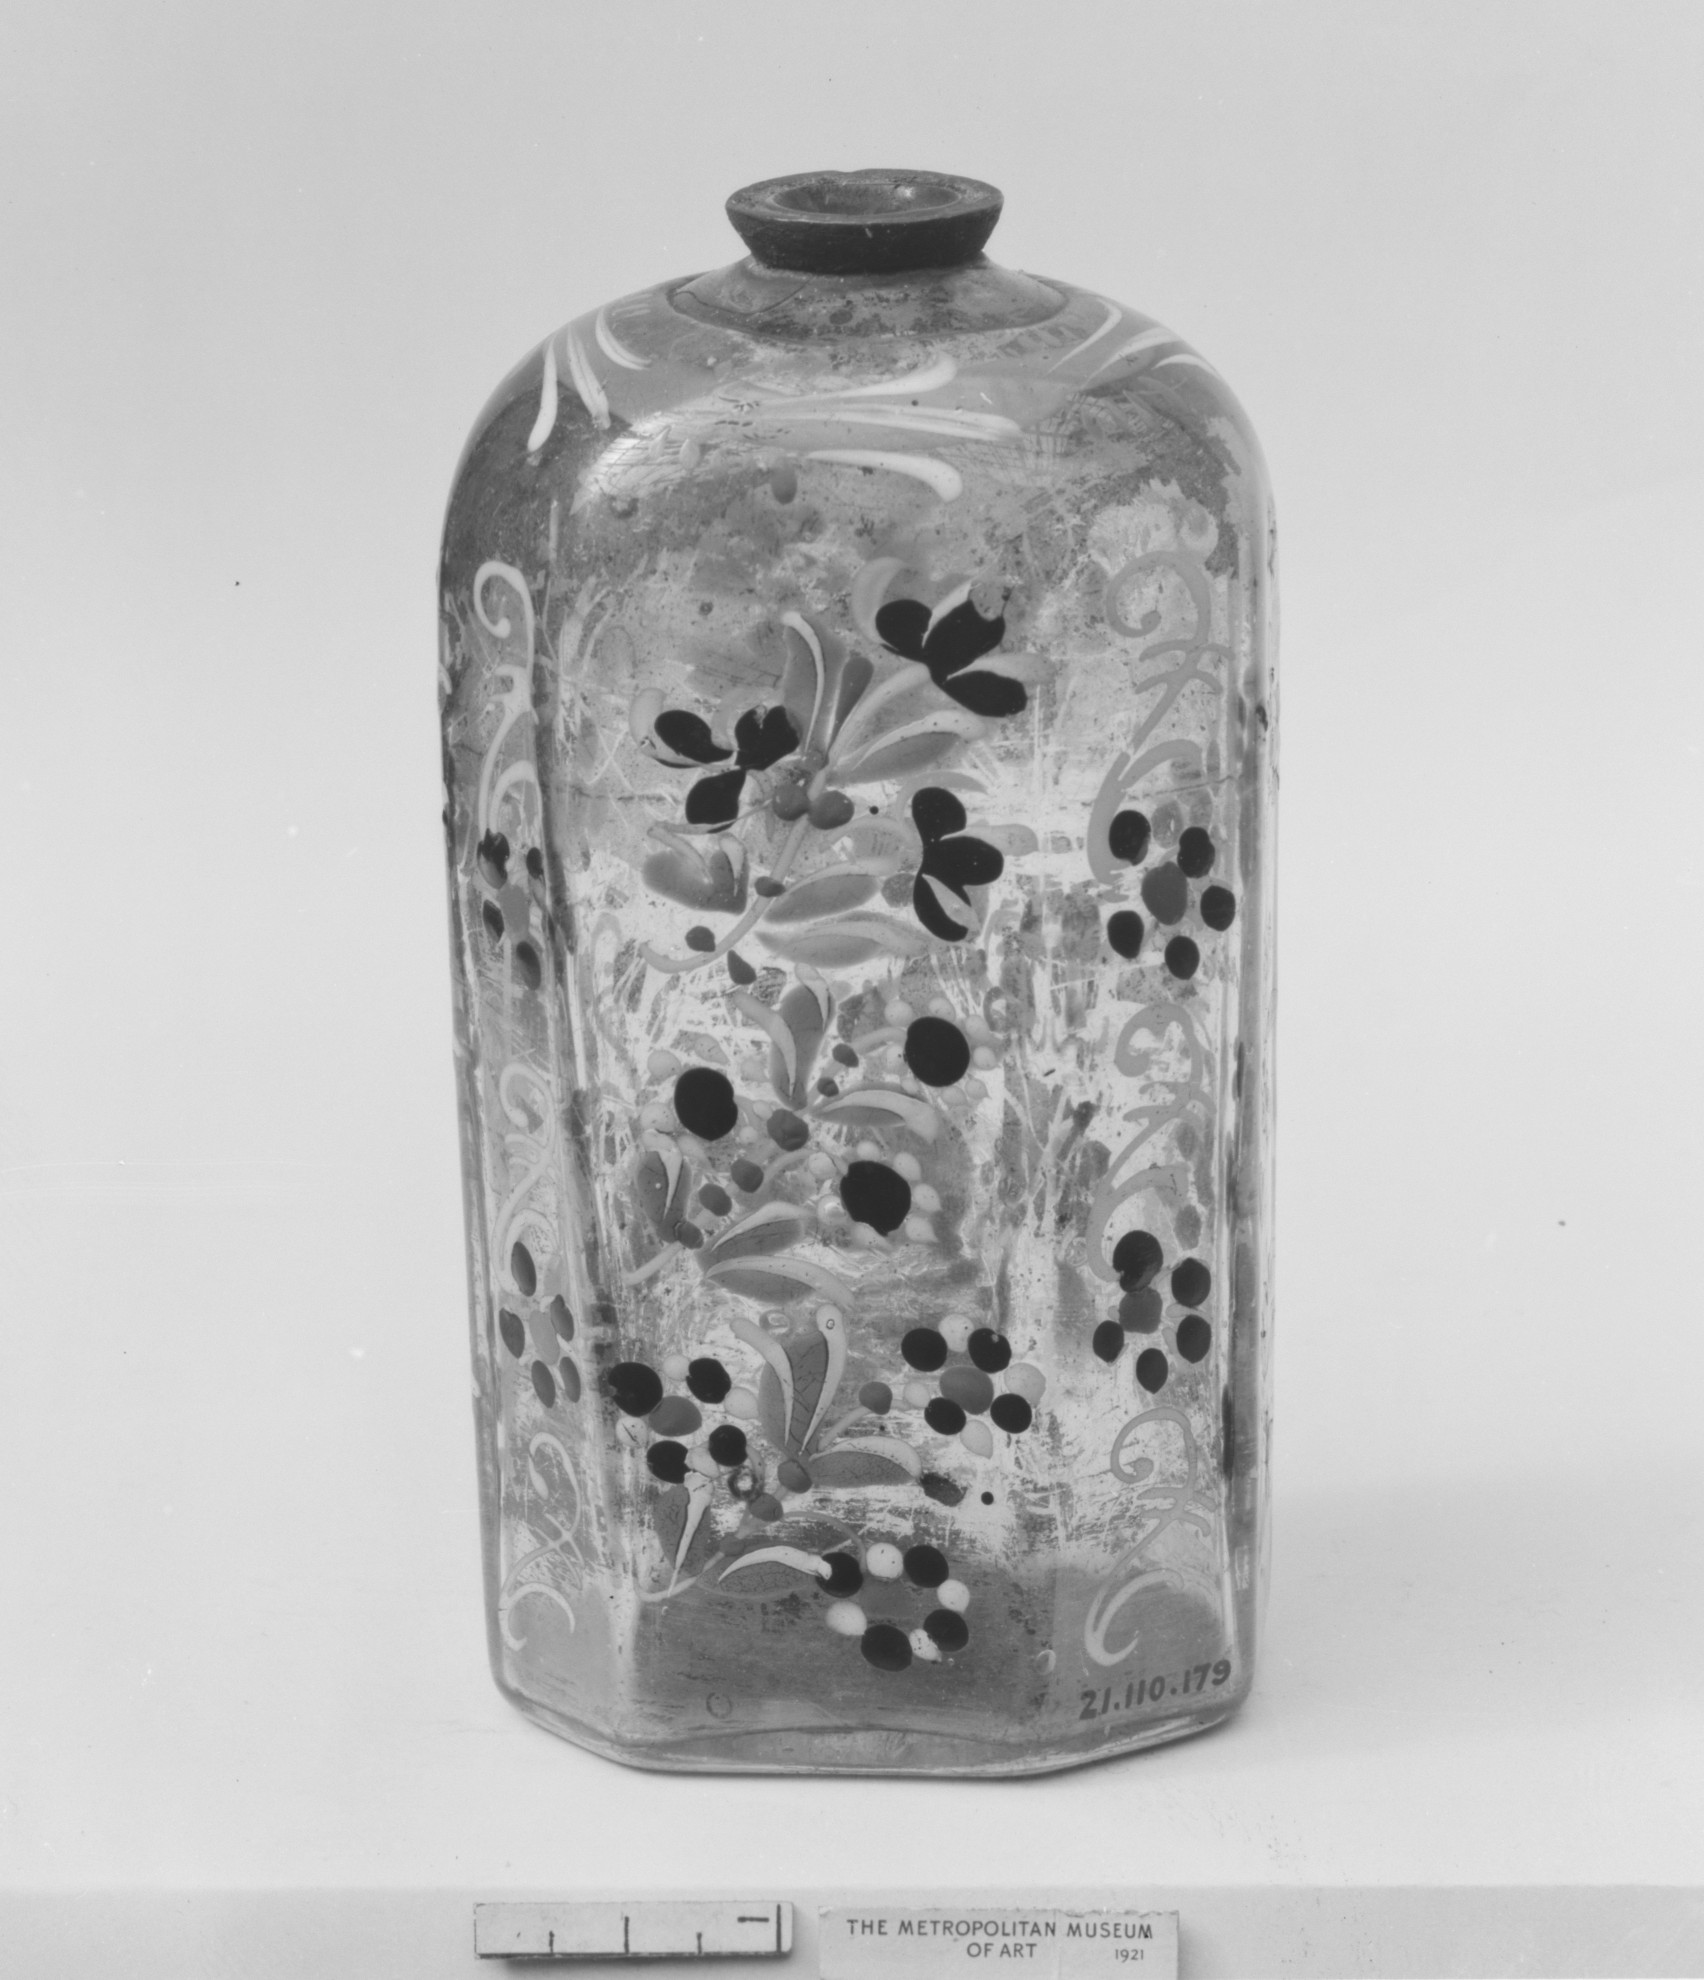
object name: bottle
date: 1701-1800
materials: glass, metal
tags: flowers